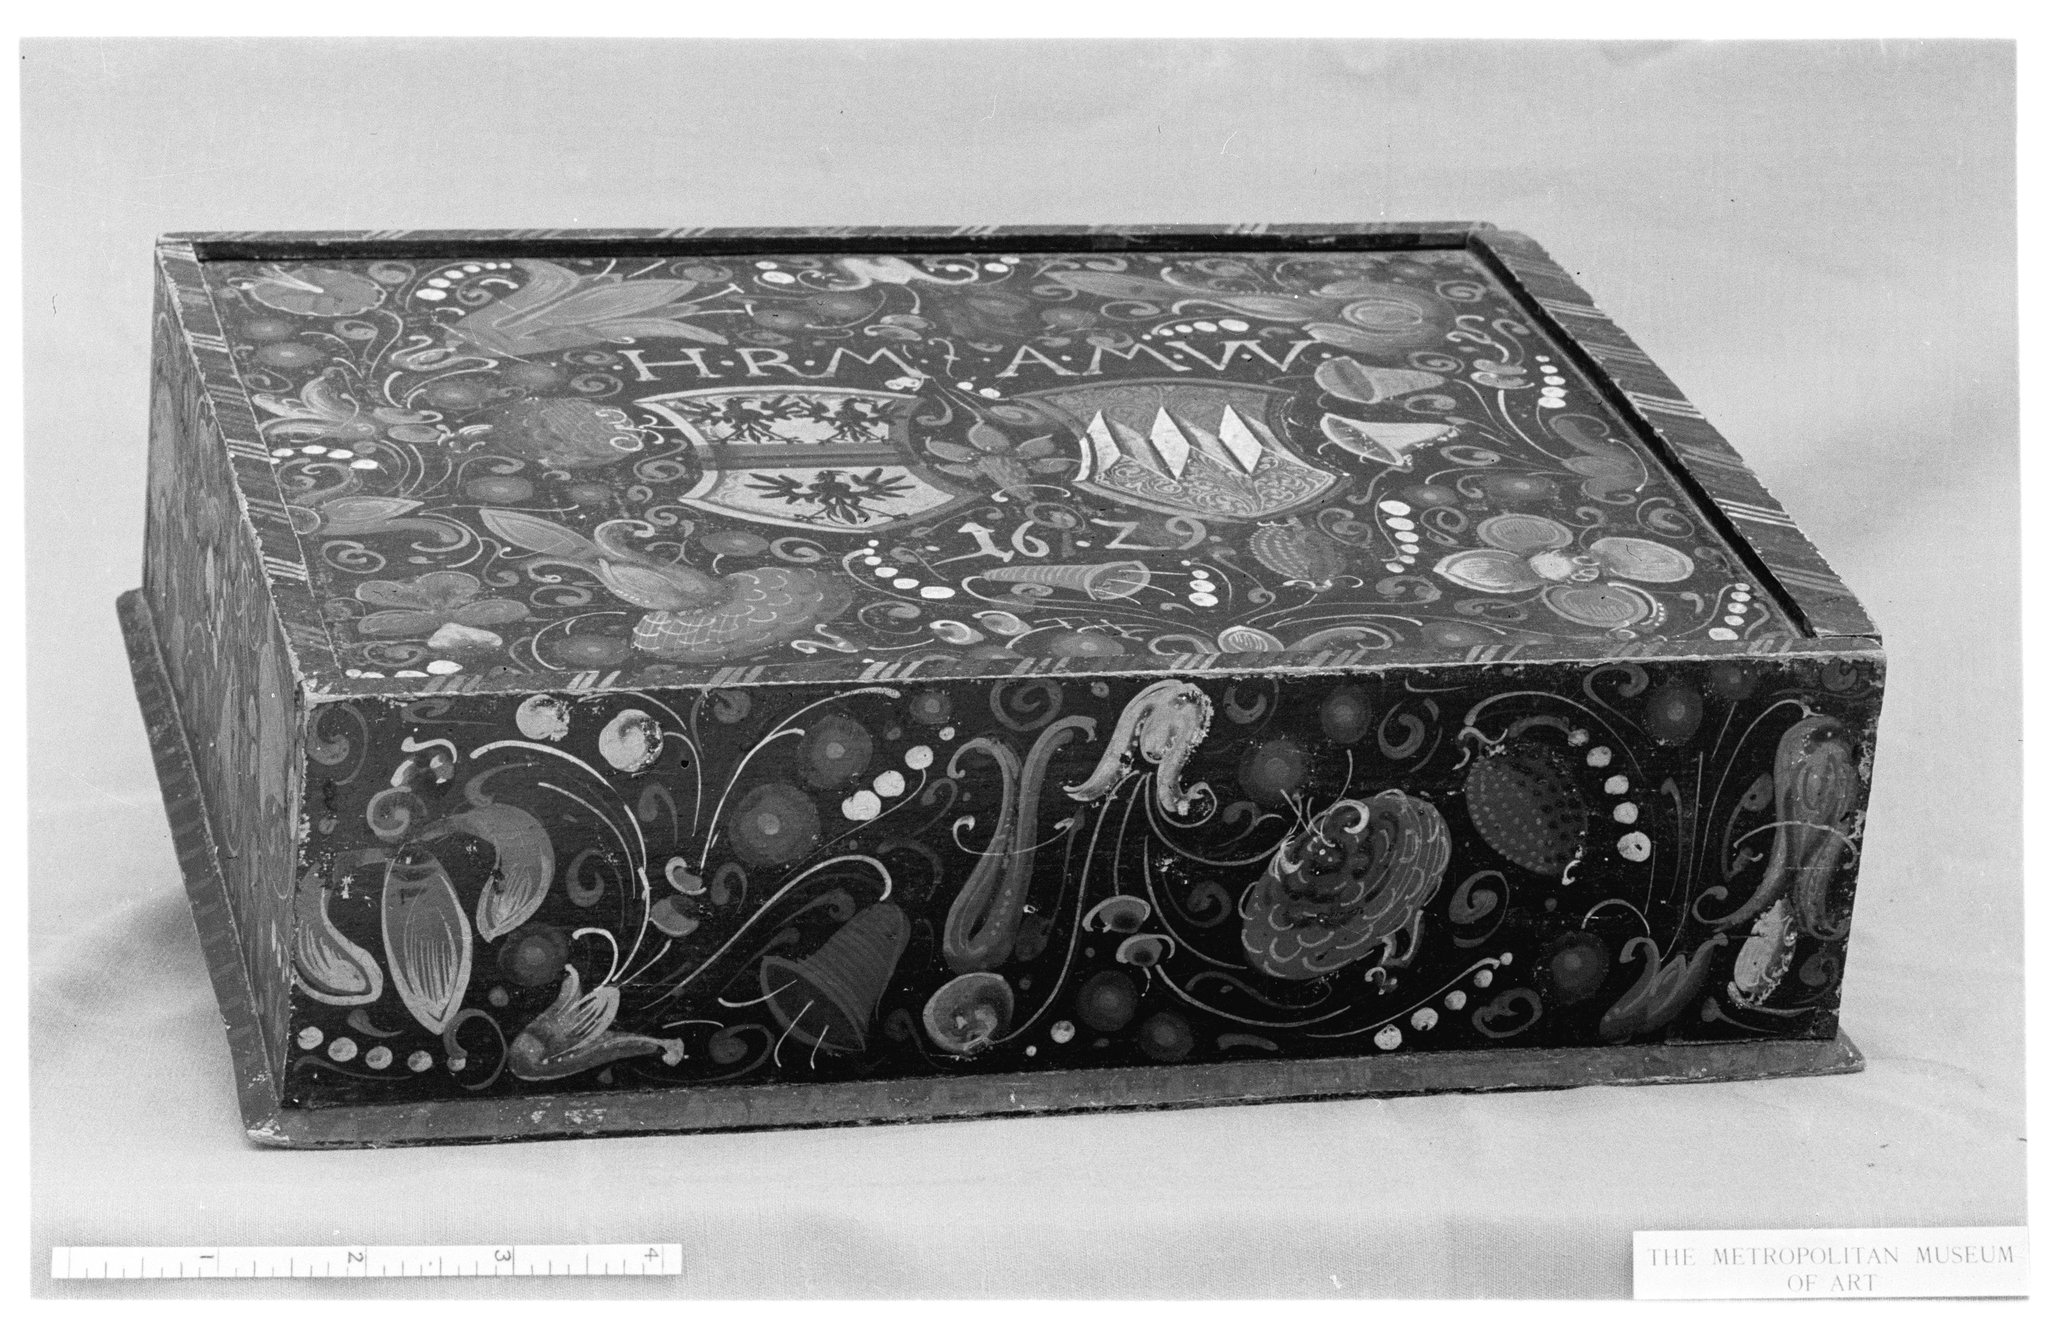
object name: box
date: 1601-1700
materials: wood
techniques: painting